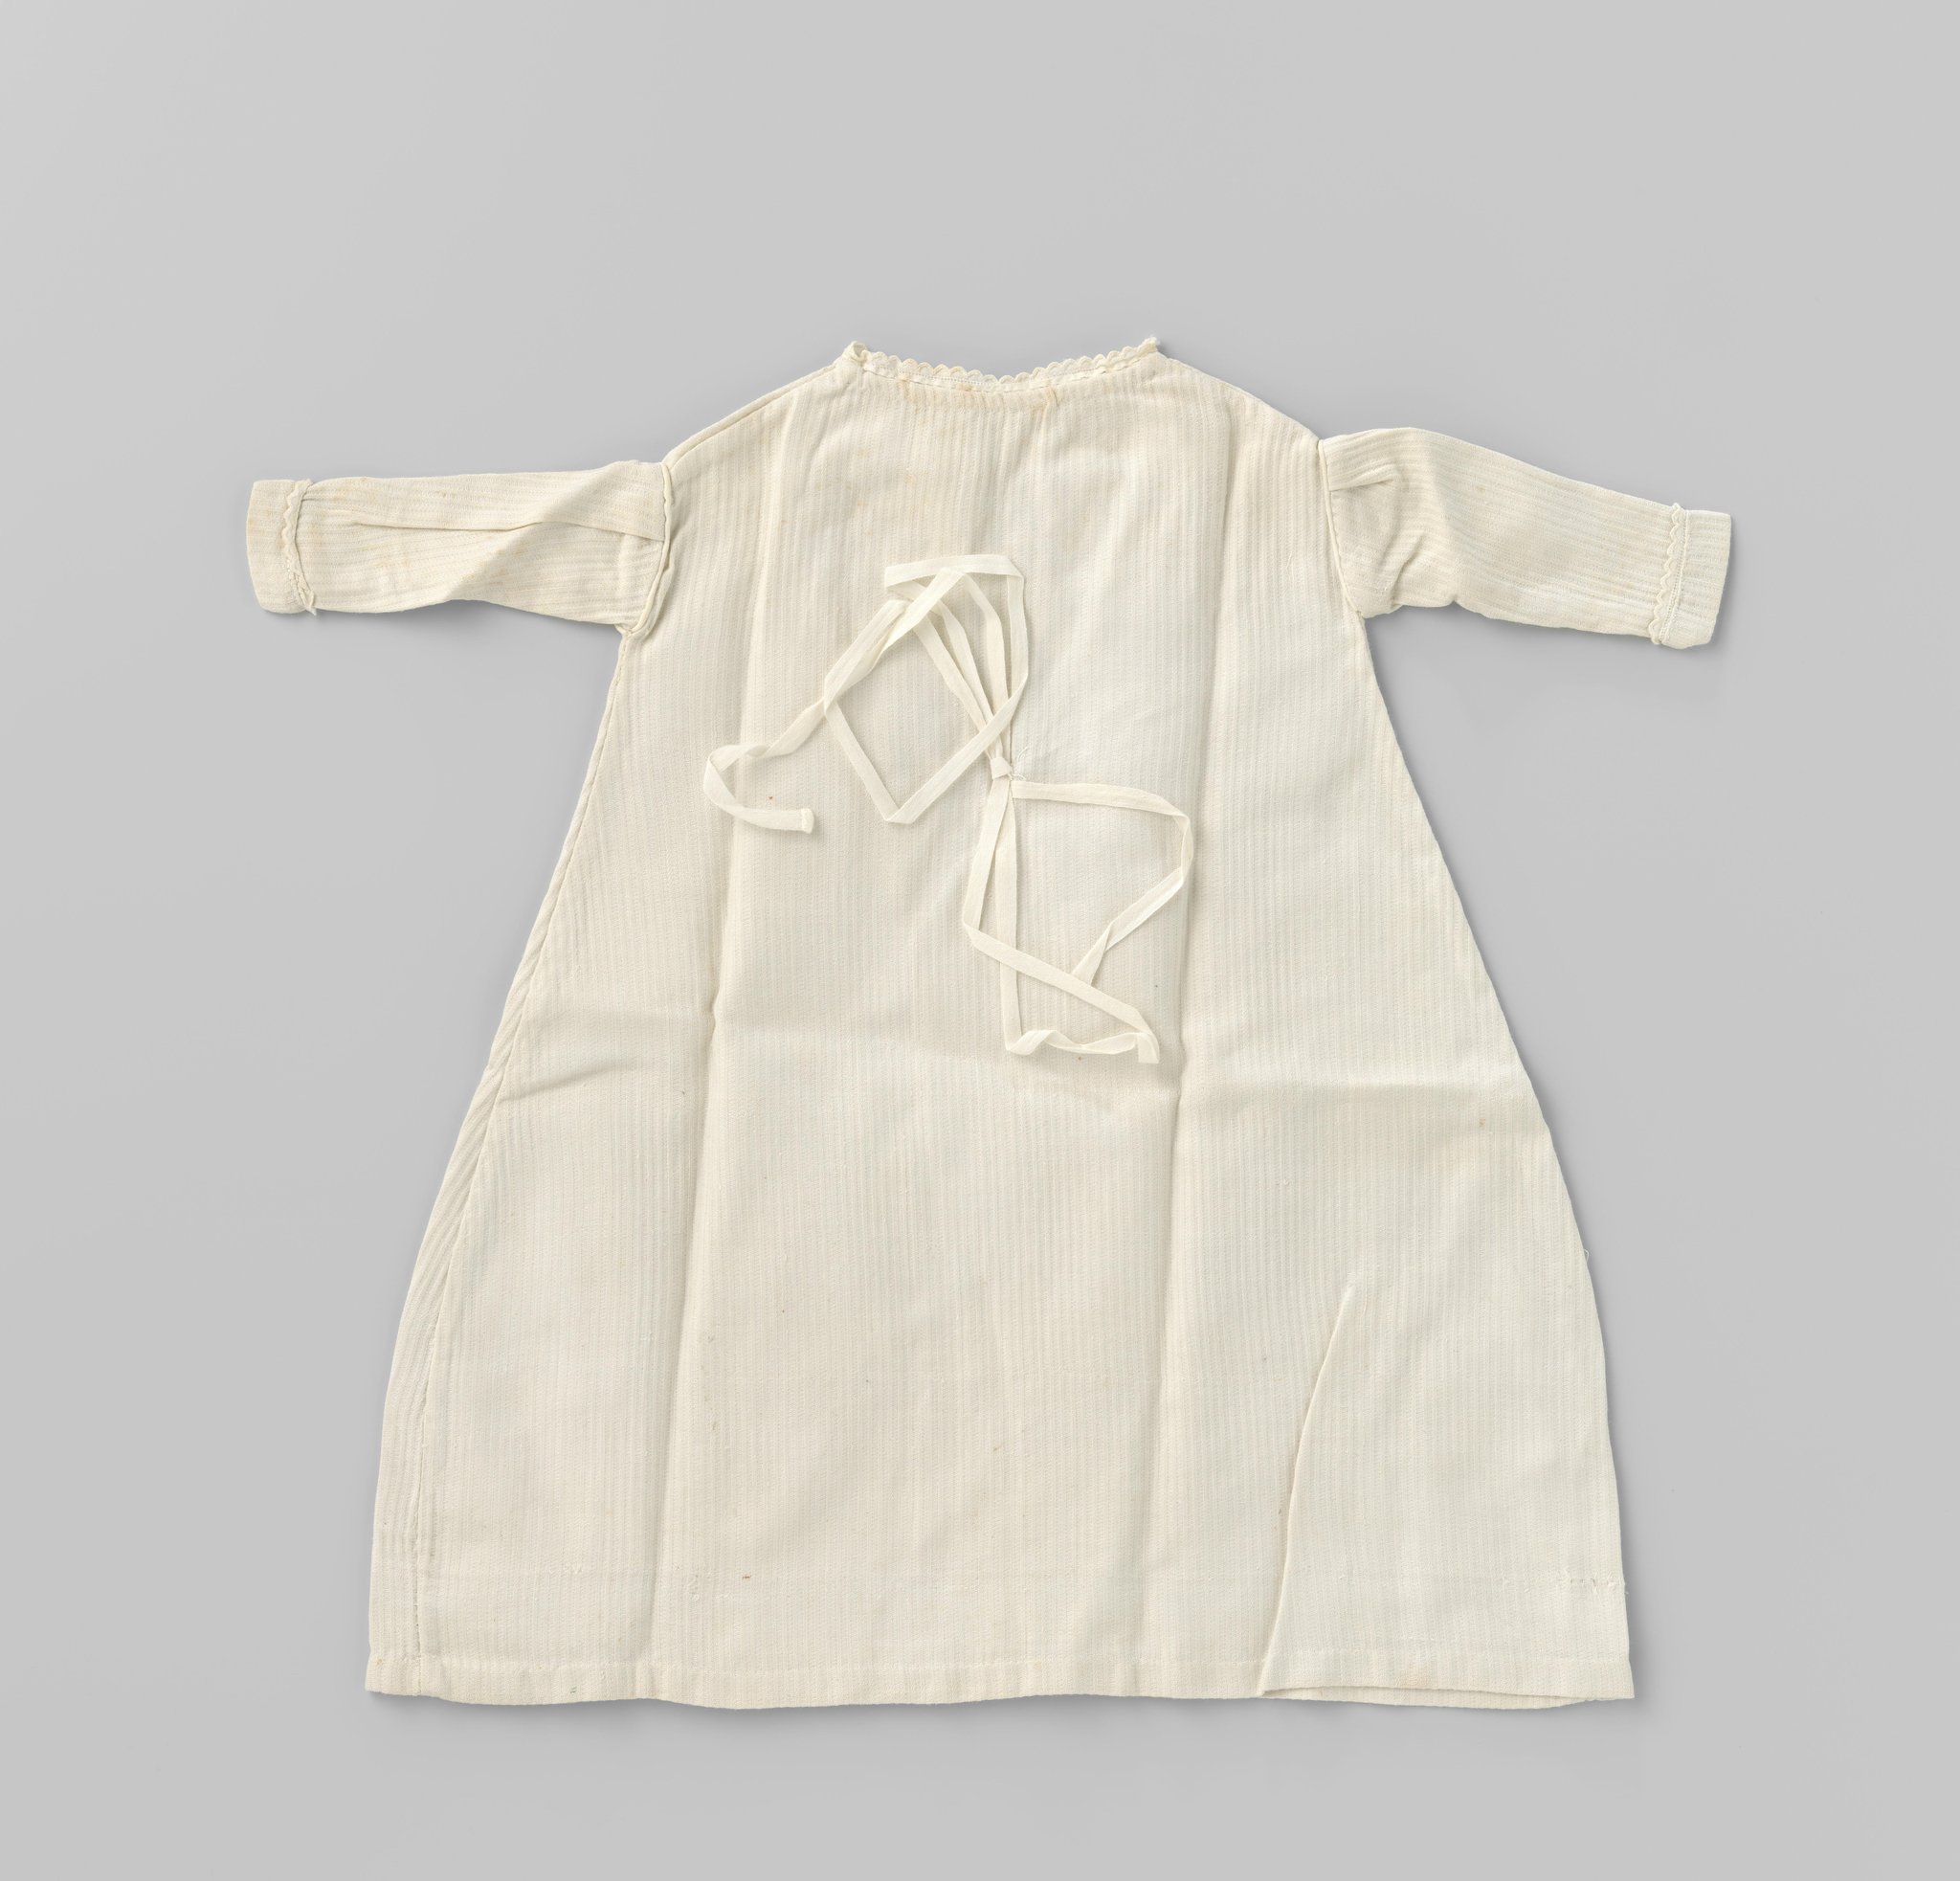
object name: toy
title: Hemd voor pop van wit linnen met ingeweven verticale strepen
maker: Anonymous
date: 1850-1920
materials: textile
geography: netherlands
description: Het hemd heeft lange mouwen en is langs de hals en aan het uiteinde van de mouwen afgezet met een rand witte kant. Aan de voorzijde in het midden een wit lint.